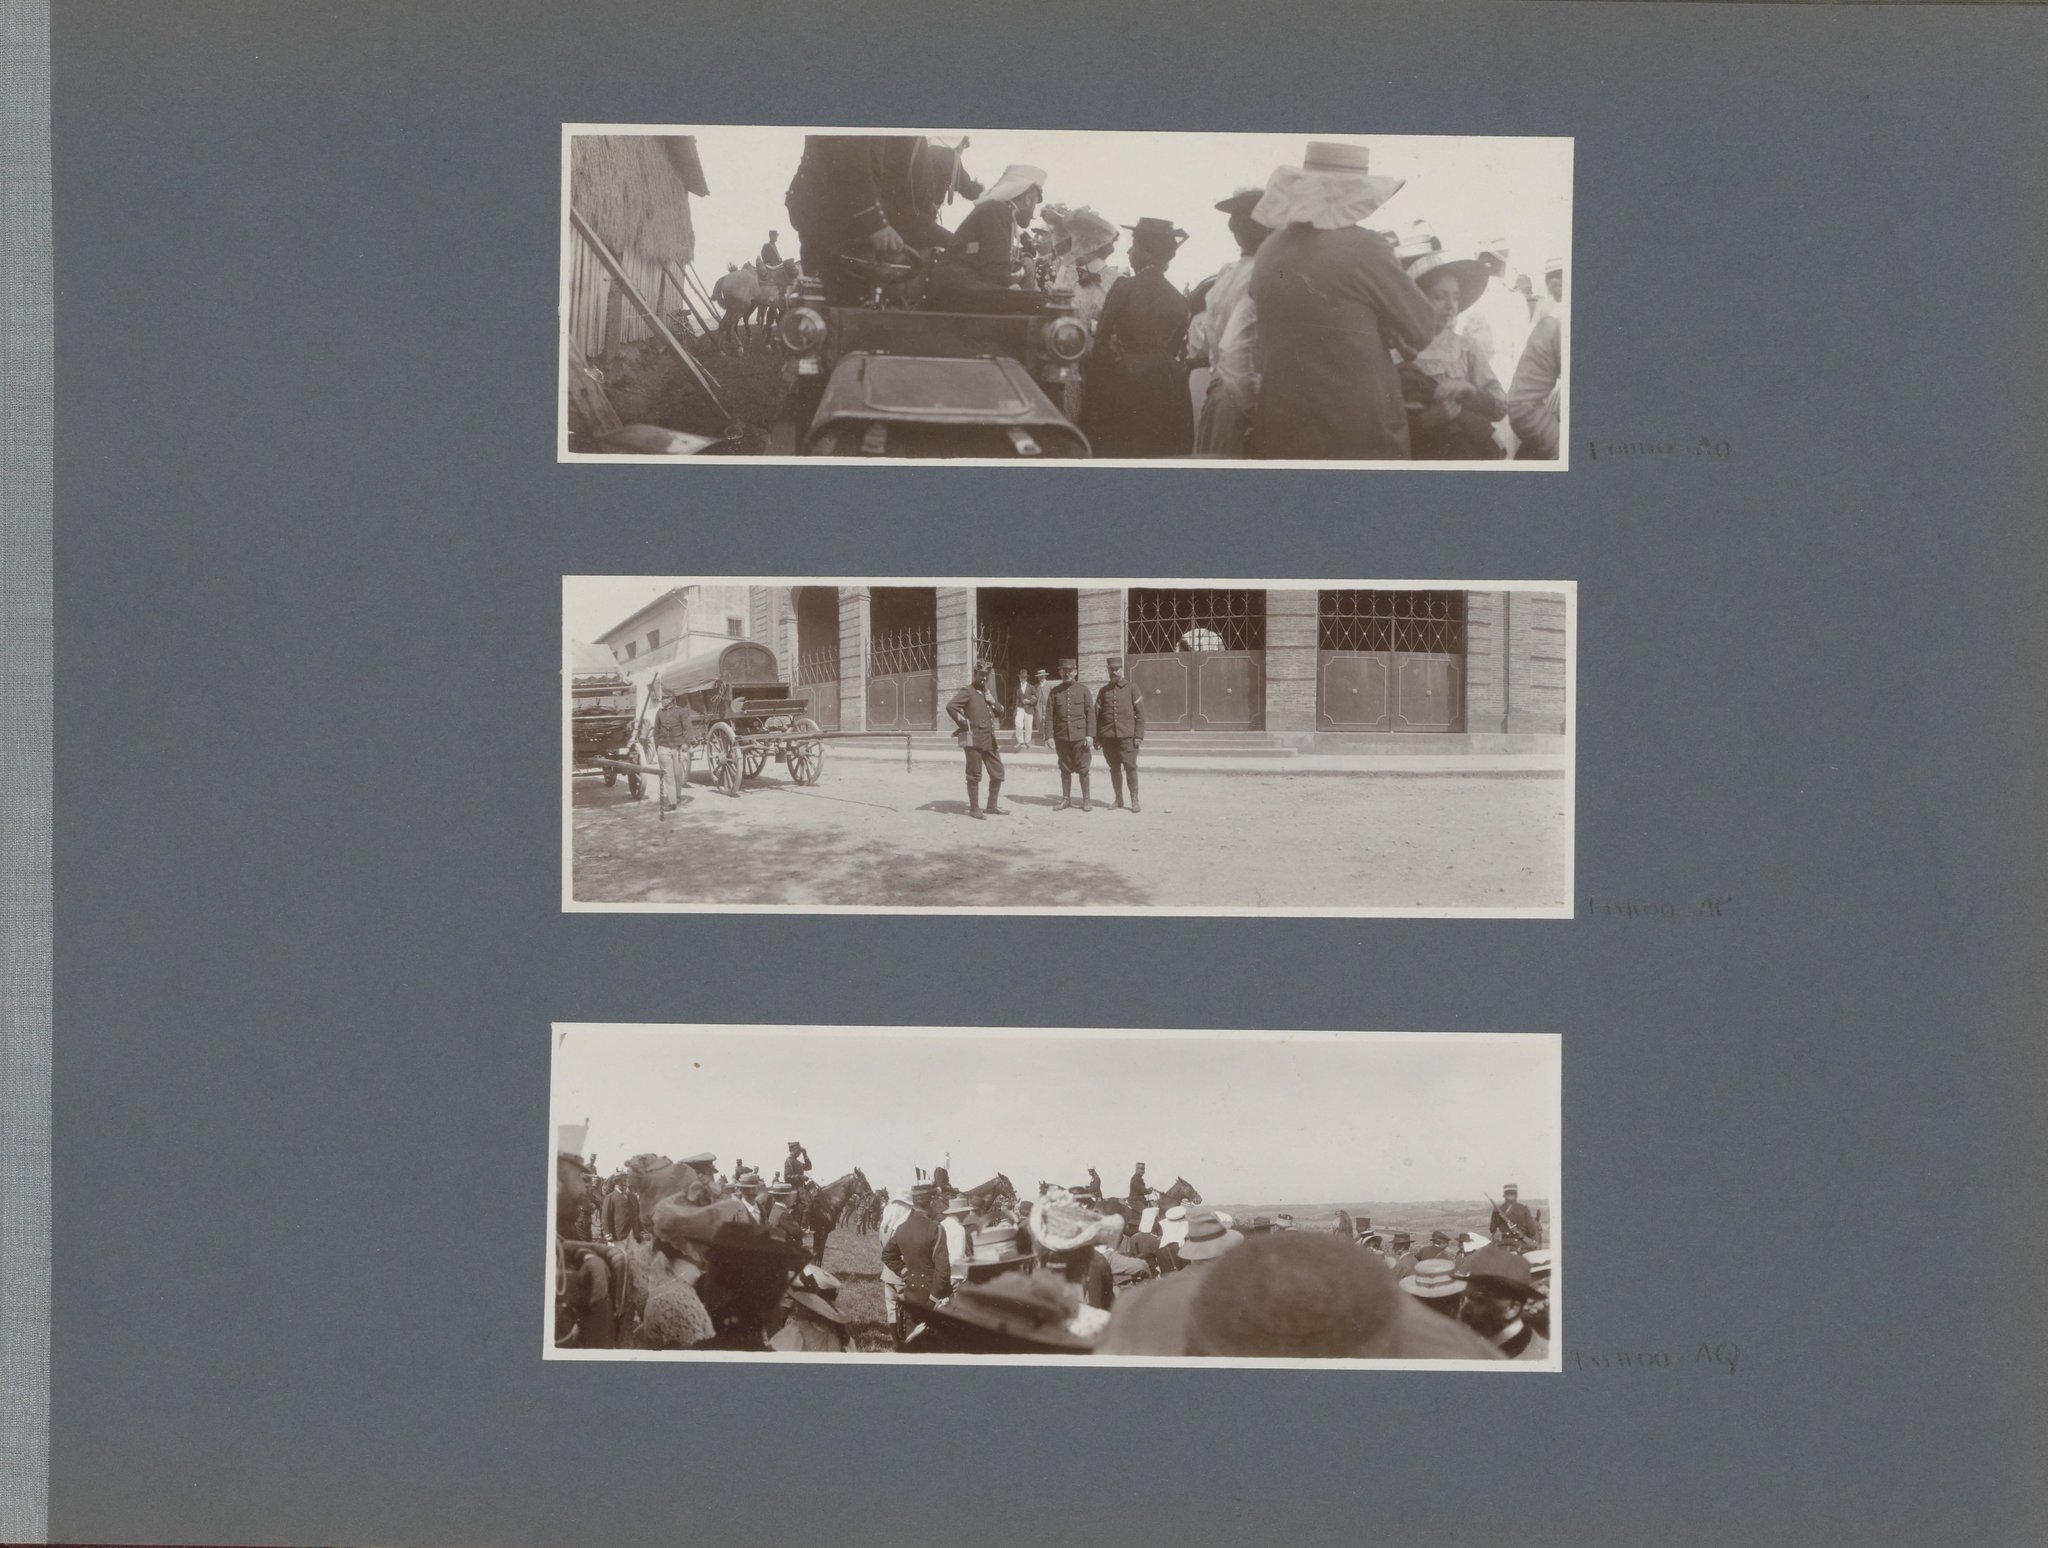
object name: album leaf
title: Cavalerie temidden van publiek in Frankrijk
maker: Anonymous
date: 1902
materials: paper, photographic support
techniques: daylight paper print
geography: france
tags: land forces (+ cavalry, horsemen), france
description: Onderdeel van Fotoalbum van een legeroefening in Zuidwest-Frankrijk in 1902.